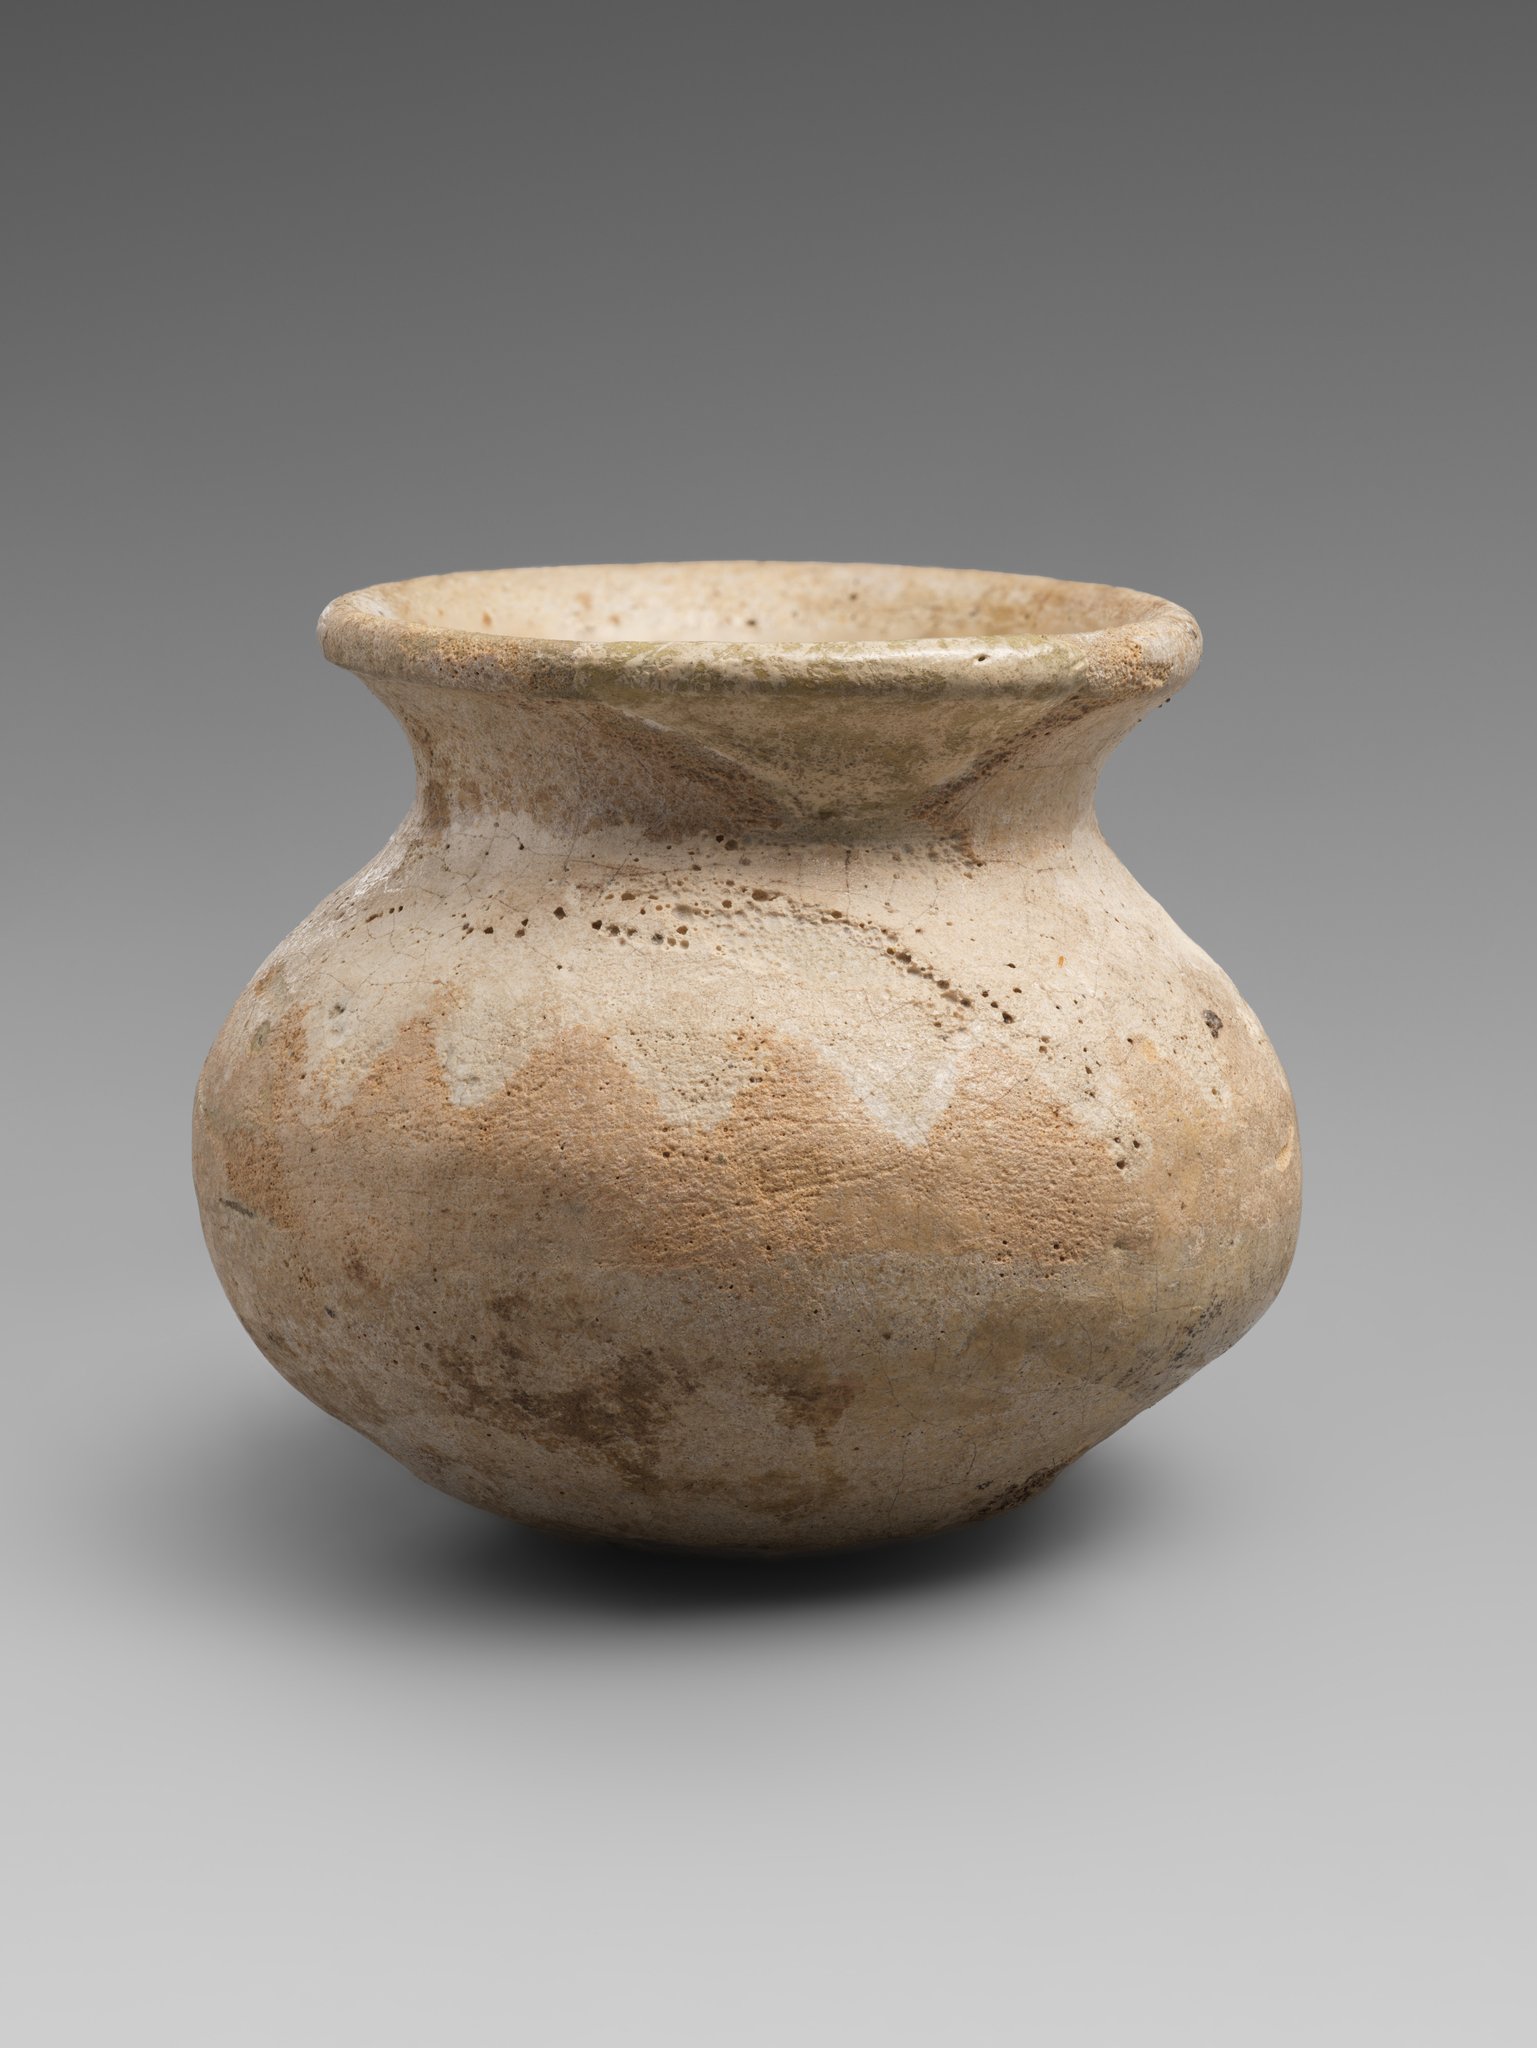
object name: jar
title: Jar with geometric decoration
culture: assyrian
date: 800-601 BCE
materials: ceramic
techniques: glazing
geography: mesopotamia